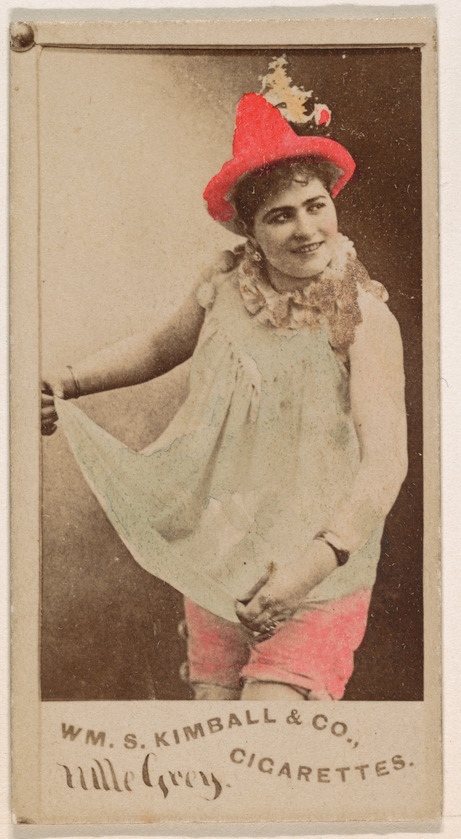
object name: photograph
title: Mlle. Grey, from the Actresses series (N203) issued by Wm. S. Kimball & Co.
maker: william s. kimball & company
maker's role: publisher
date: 1889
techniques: color lithograph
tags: portraits,women,actresses